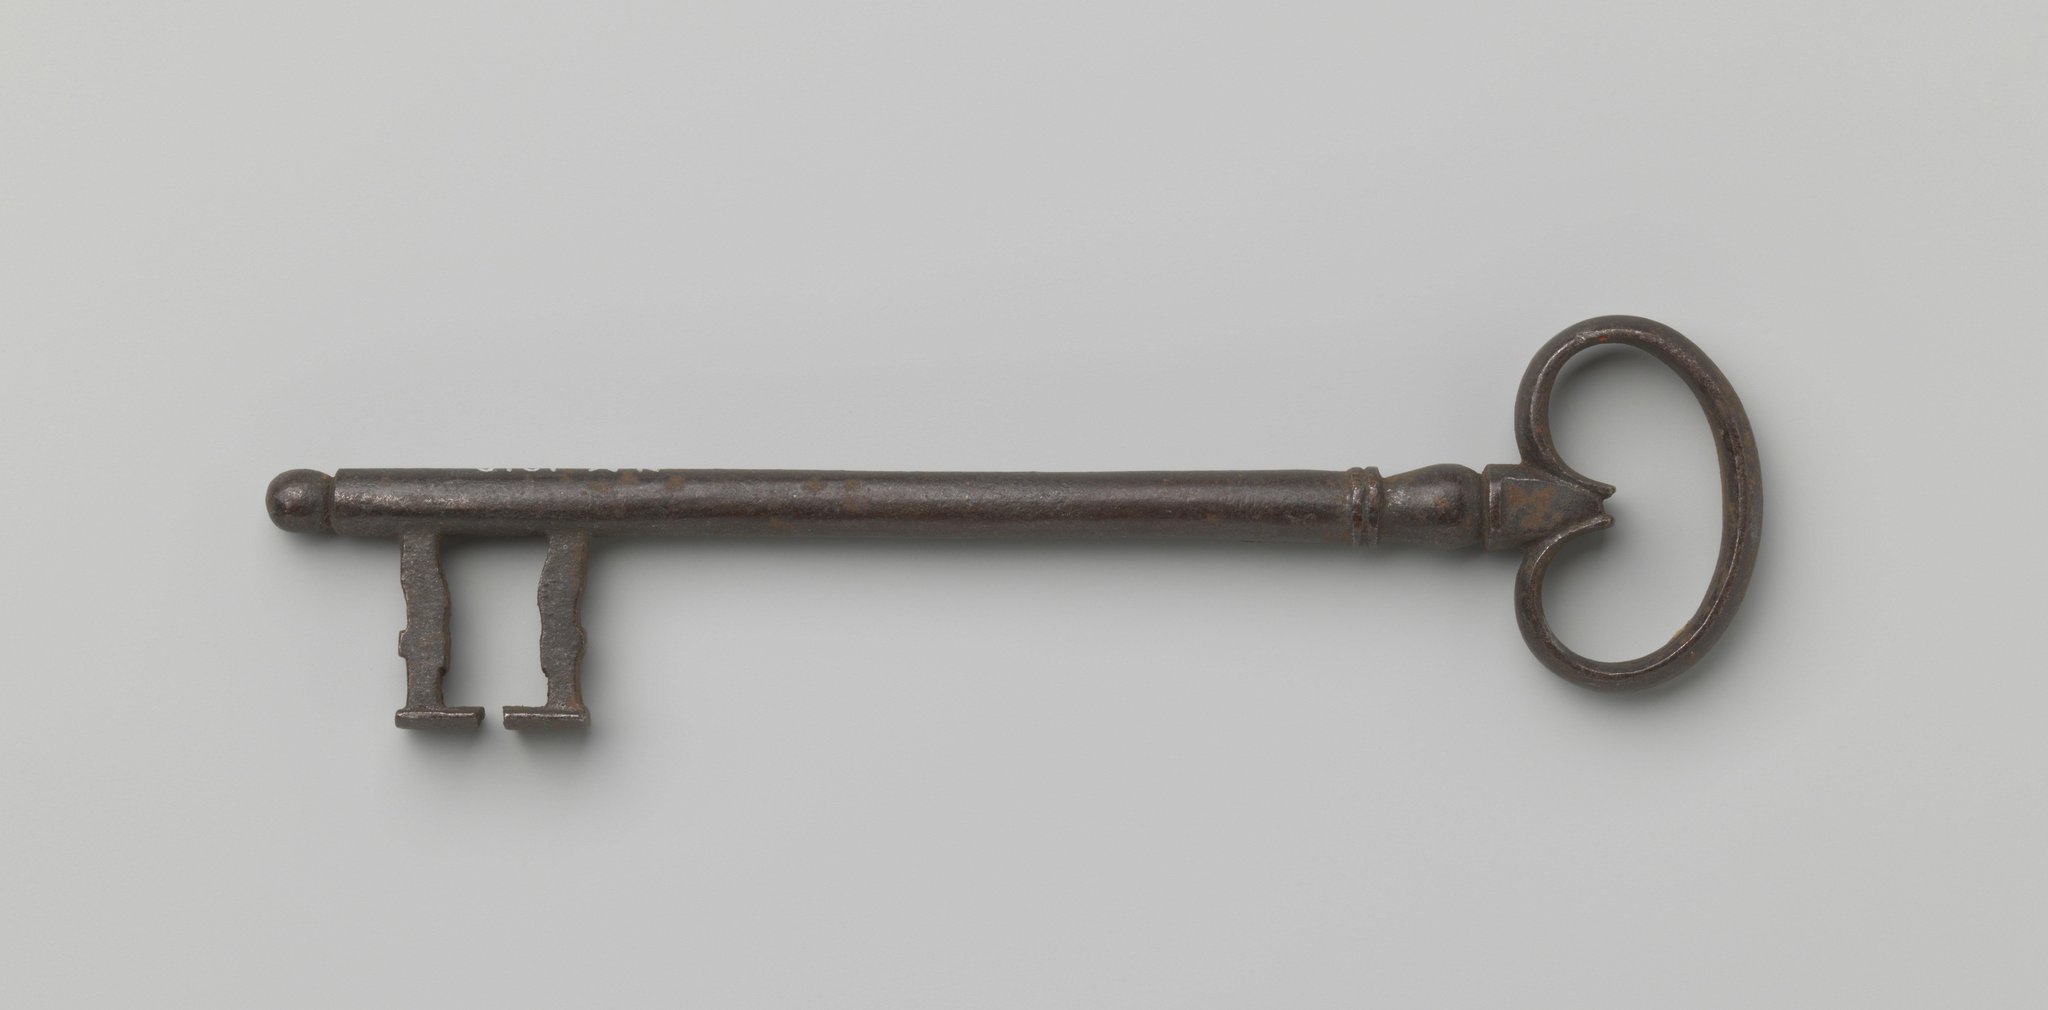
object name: key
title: IJzeren sleutel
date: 1400-1950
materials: iron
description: IJzeren sleutel, voorheen aan een stalen ring bevestigd (tezamen met de nummers 1019 t/m 1084).